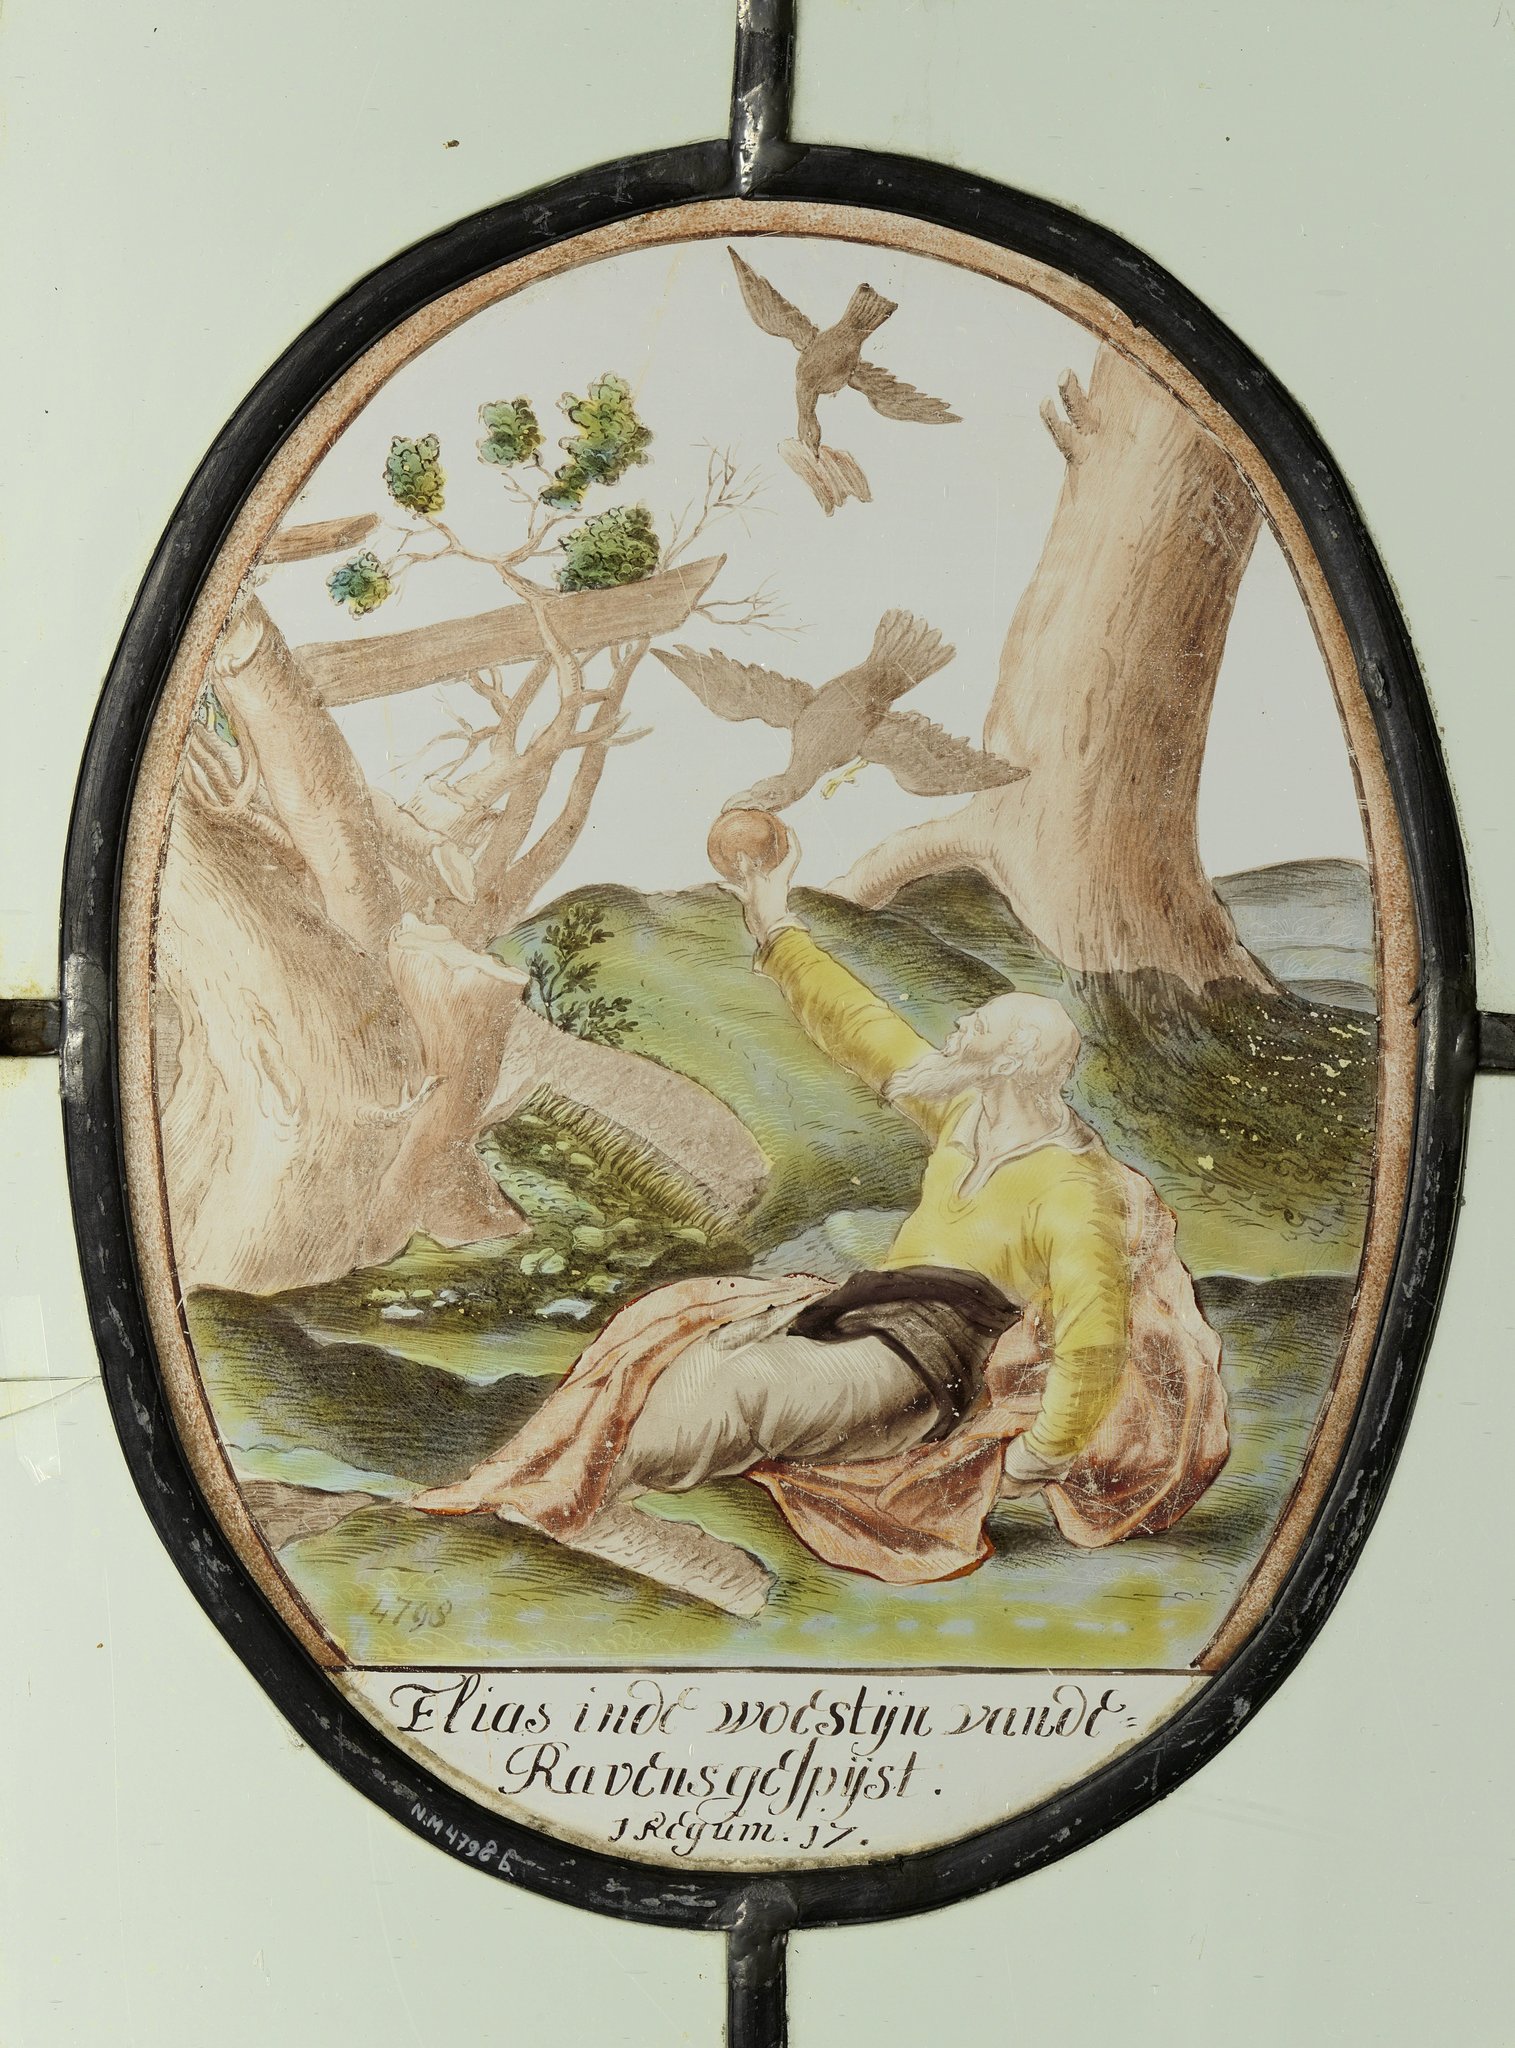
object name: light window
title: Ruit met Elias in de woestijn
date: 1600-1650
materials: glass, lead, pigment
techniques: leading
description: Ovale gebrandschilderde ruit waarop afgebeeld Elias in de woestijn. Met onderschrift "Elias in de Woestyn van de Ravens gespijst".